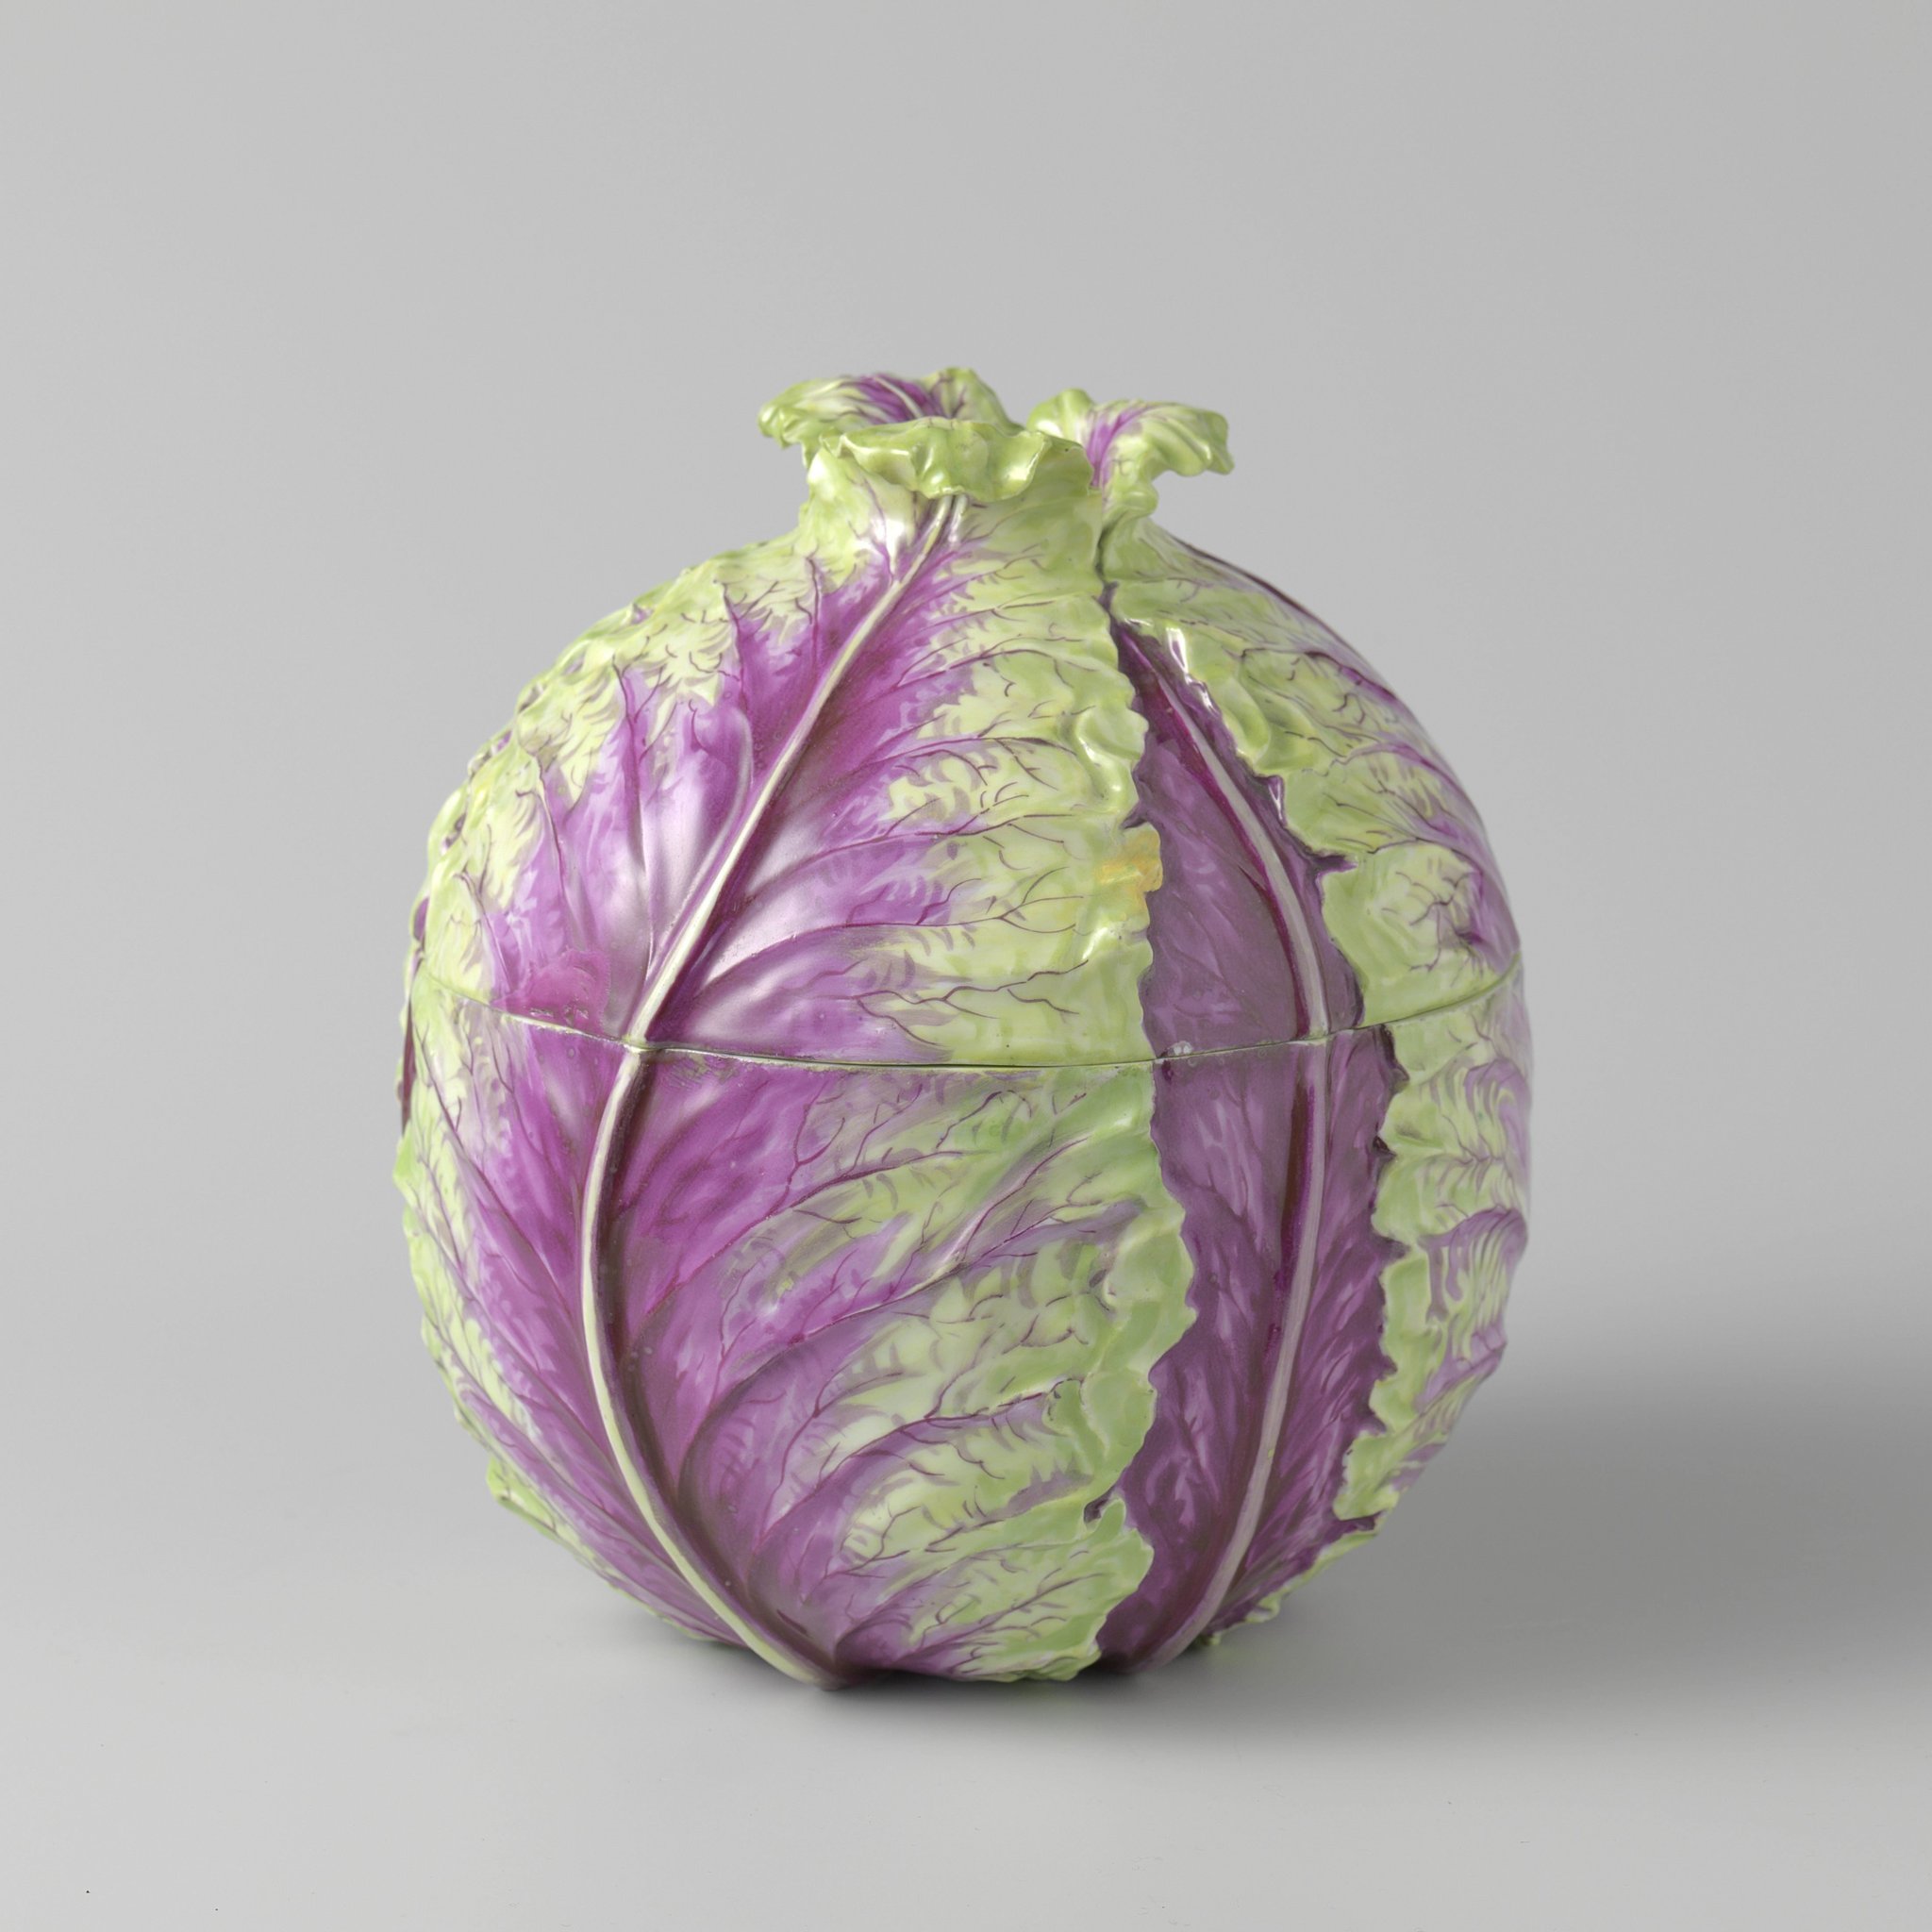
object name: tureen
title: Terrine in the shape of a red cabbage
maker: johann joachim kändler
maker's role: designer, sculptor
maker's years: 1706-1775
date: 1769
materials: porcelain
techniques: painted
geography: meissen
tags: plants and herbs: cabbage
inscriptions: factory mark, painter's mark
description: Terrine met deksel, van porselein, in de vorm van een rode kool. De terrine is gemerkt.